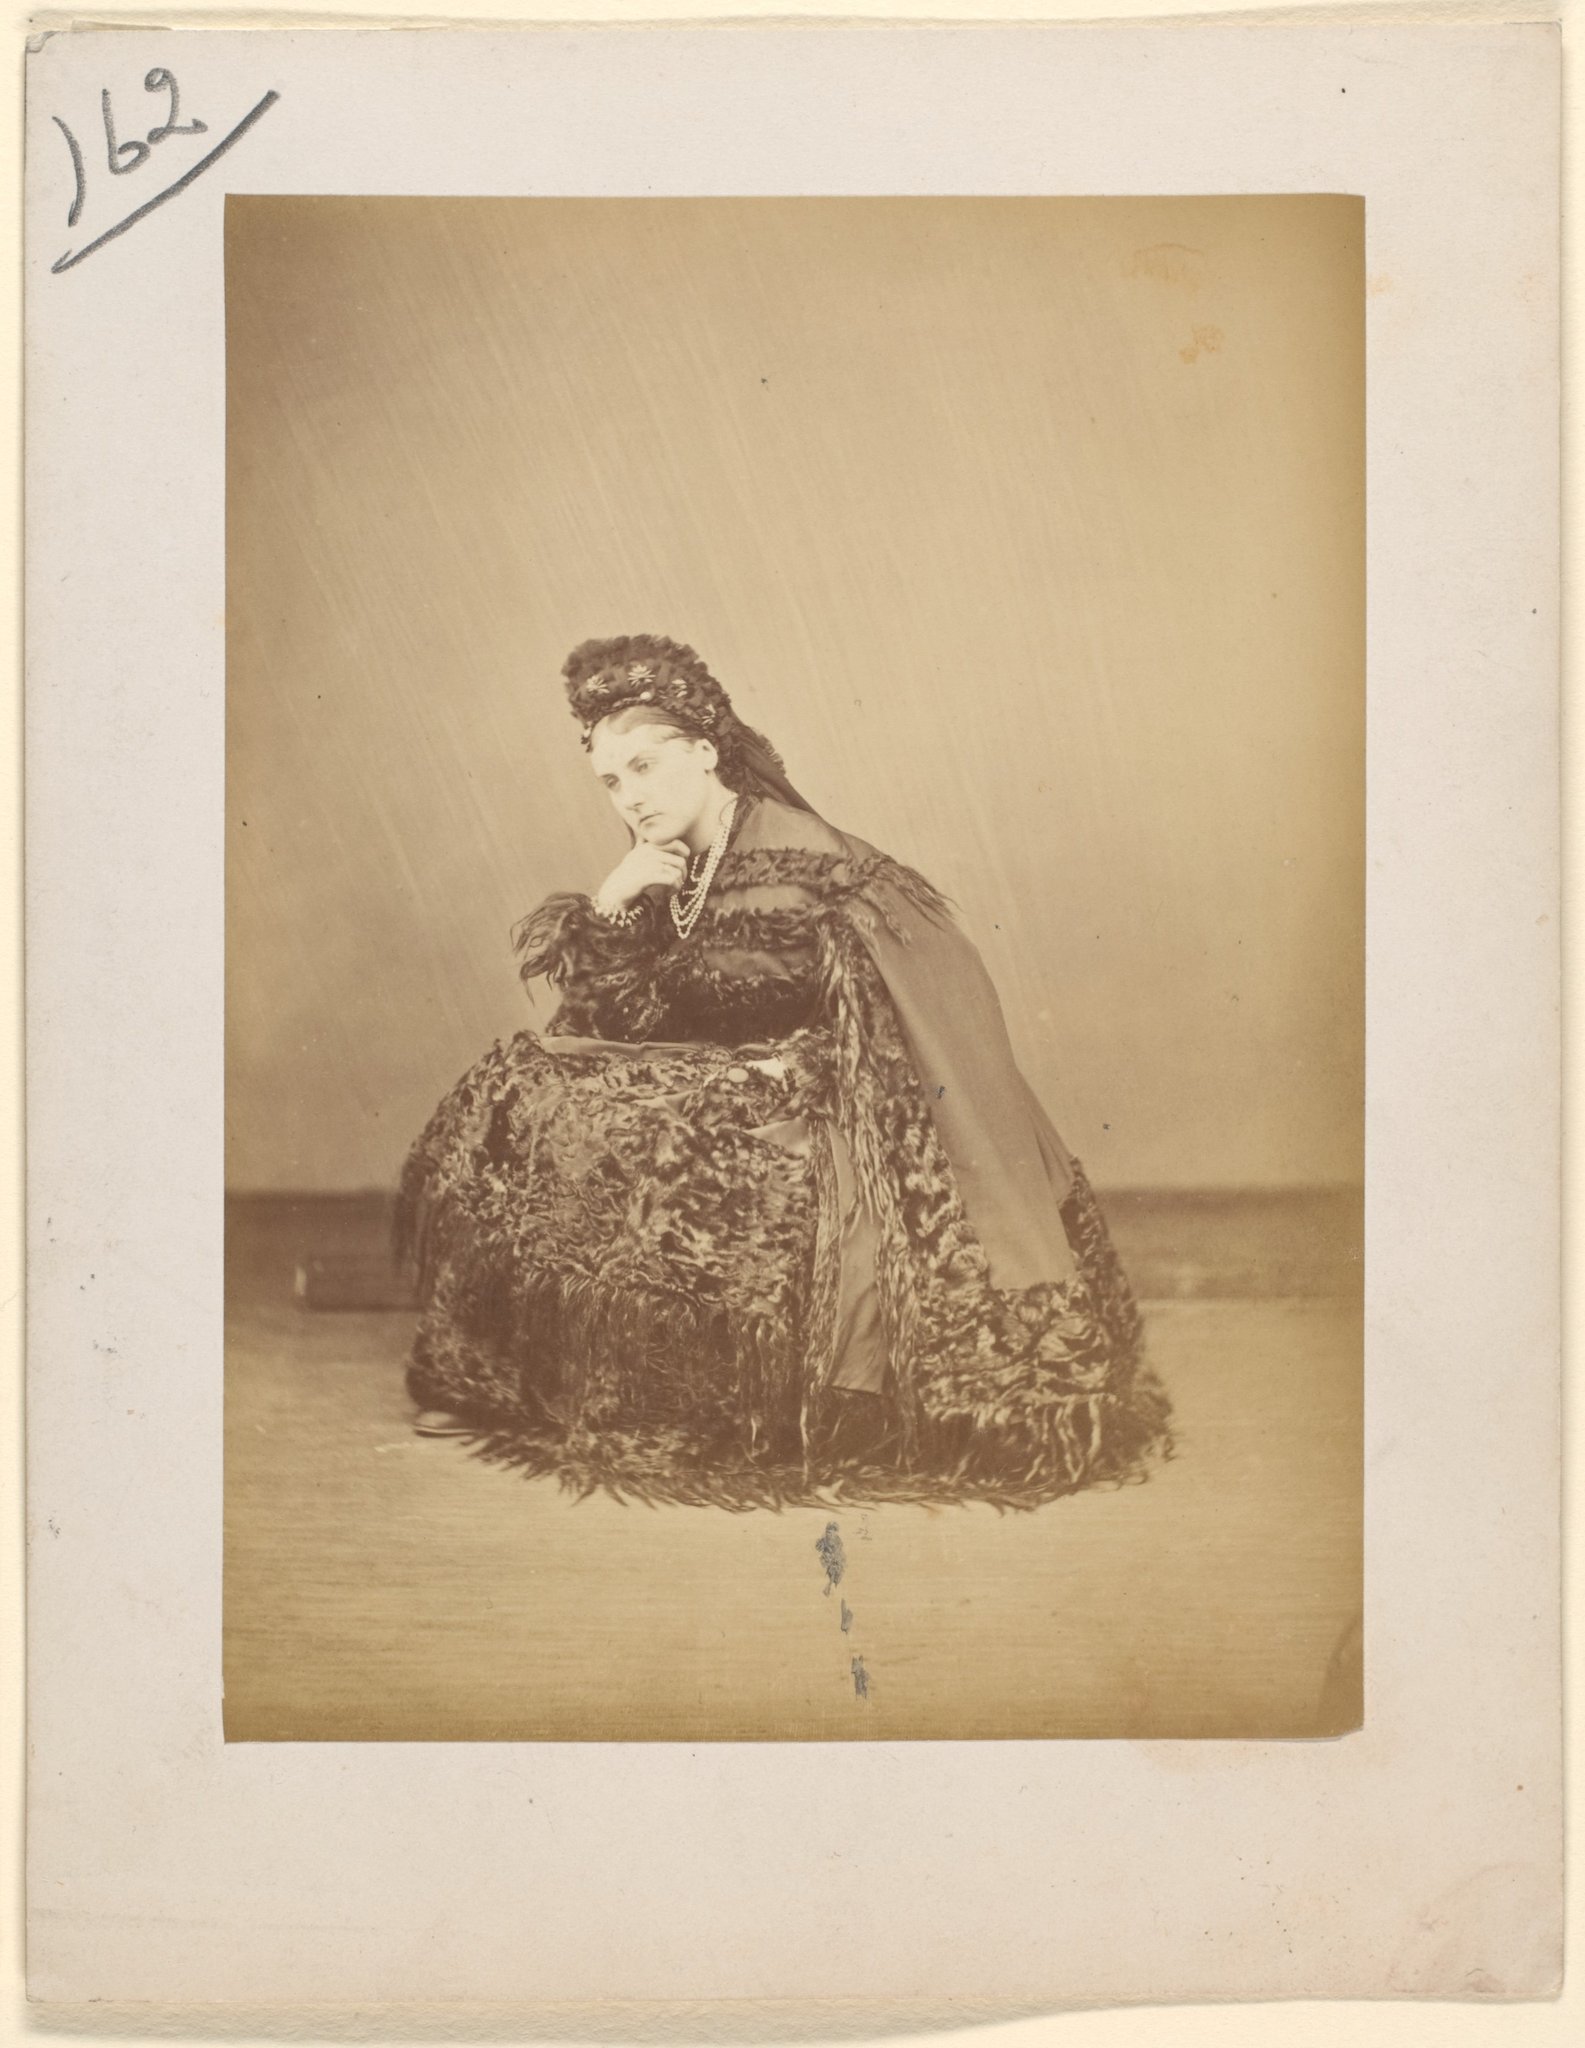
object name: photograph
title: Le Caracul (L'Astrakhan)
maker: pierre-louis pierson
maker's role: artist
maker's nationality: french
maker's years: 1822-1913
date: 1860-1869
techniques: albumen silver print, glass negative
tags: portraits,women